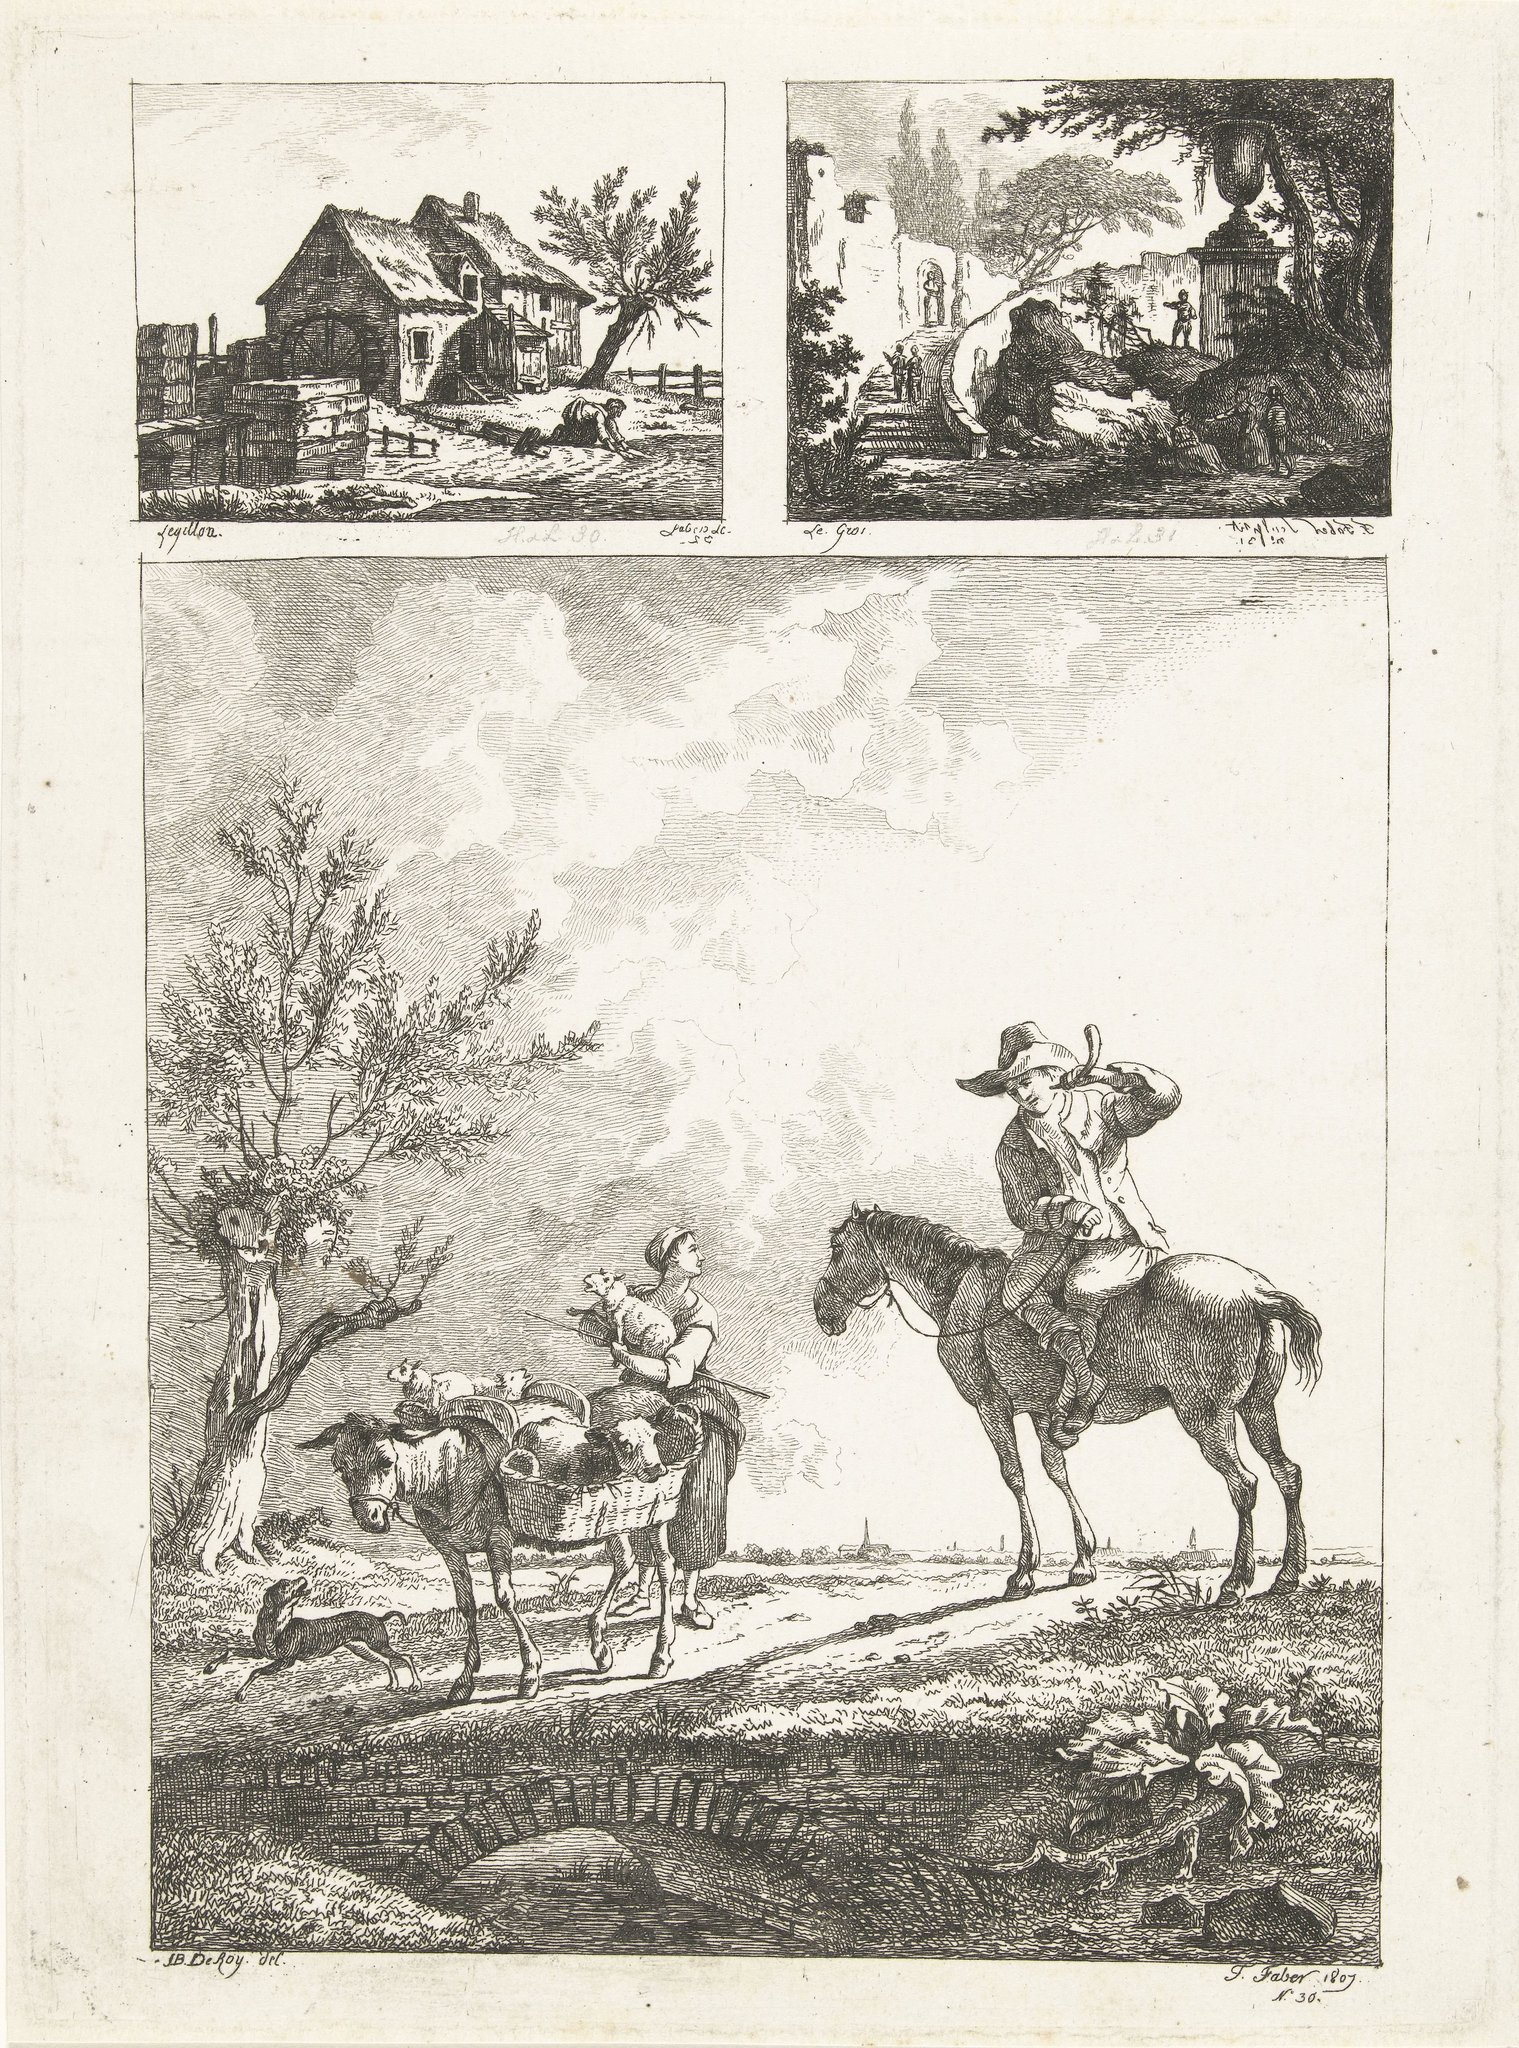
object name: print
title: Watermolen, ruïne en herderin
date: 1807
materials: paper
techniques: etching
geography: brussels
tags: herding, herdsman, herdswoman, shepherd, shepherdess, cowherd, etc., landscape with ruins, watermill in landscape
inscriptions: collector's mark: Lugt 2228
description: Drie voorstellingen op één blad. Linksboven: een gezicht op een watermolen. Rechtsboven: een landschap met wandelaars bij een ruïne. Onder: een herderin met een lam in haar armen omkijkend naar een man te paard met een hoorn in zijn hand.